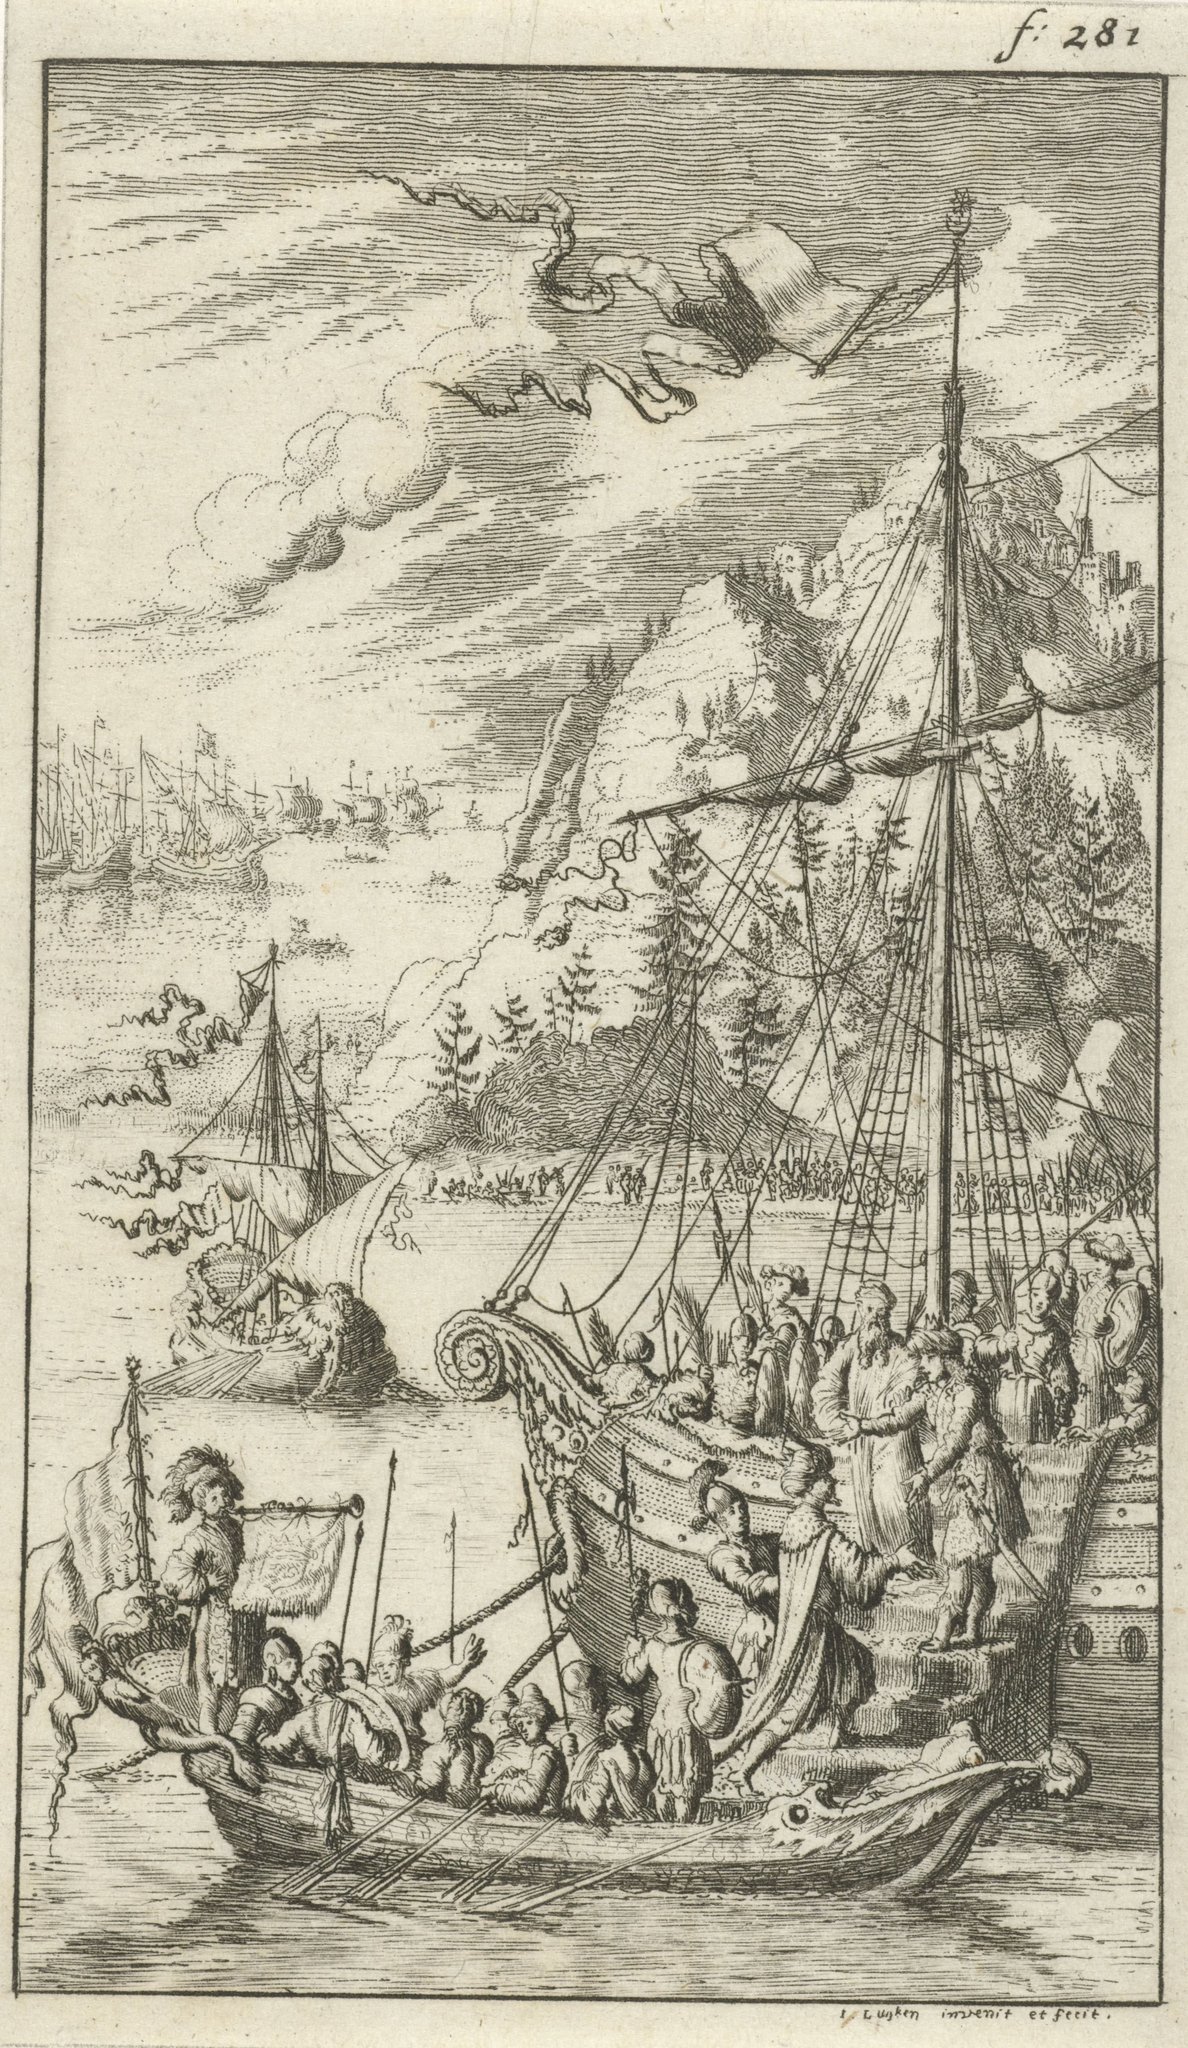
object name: book illustration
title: Ontmoeting tussen de schepen van Radirobanes en Meleander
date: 1680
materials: paper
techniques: etching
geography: amsterdam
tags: ships (in general), meeting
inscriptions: collector's mark: Lugt 2228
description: Illustratie opgenomen in het eerste deel van: Barclay, John. D'Argenis, 2 delen. Amsterdam: Jan Claesz ten Hoorn, 1680-1681.